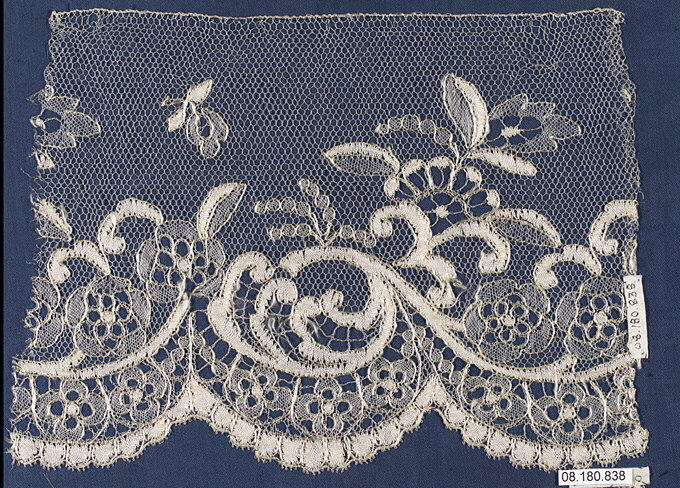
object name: piece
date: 1801-1900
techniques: lace